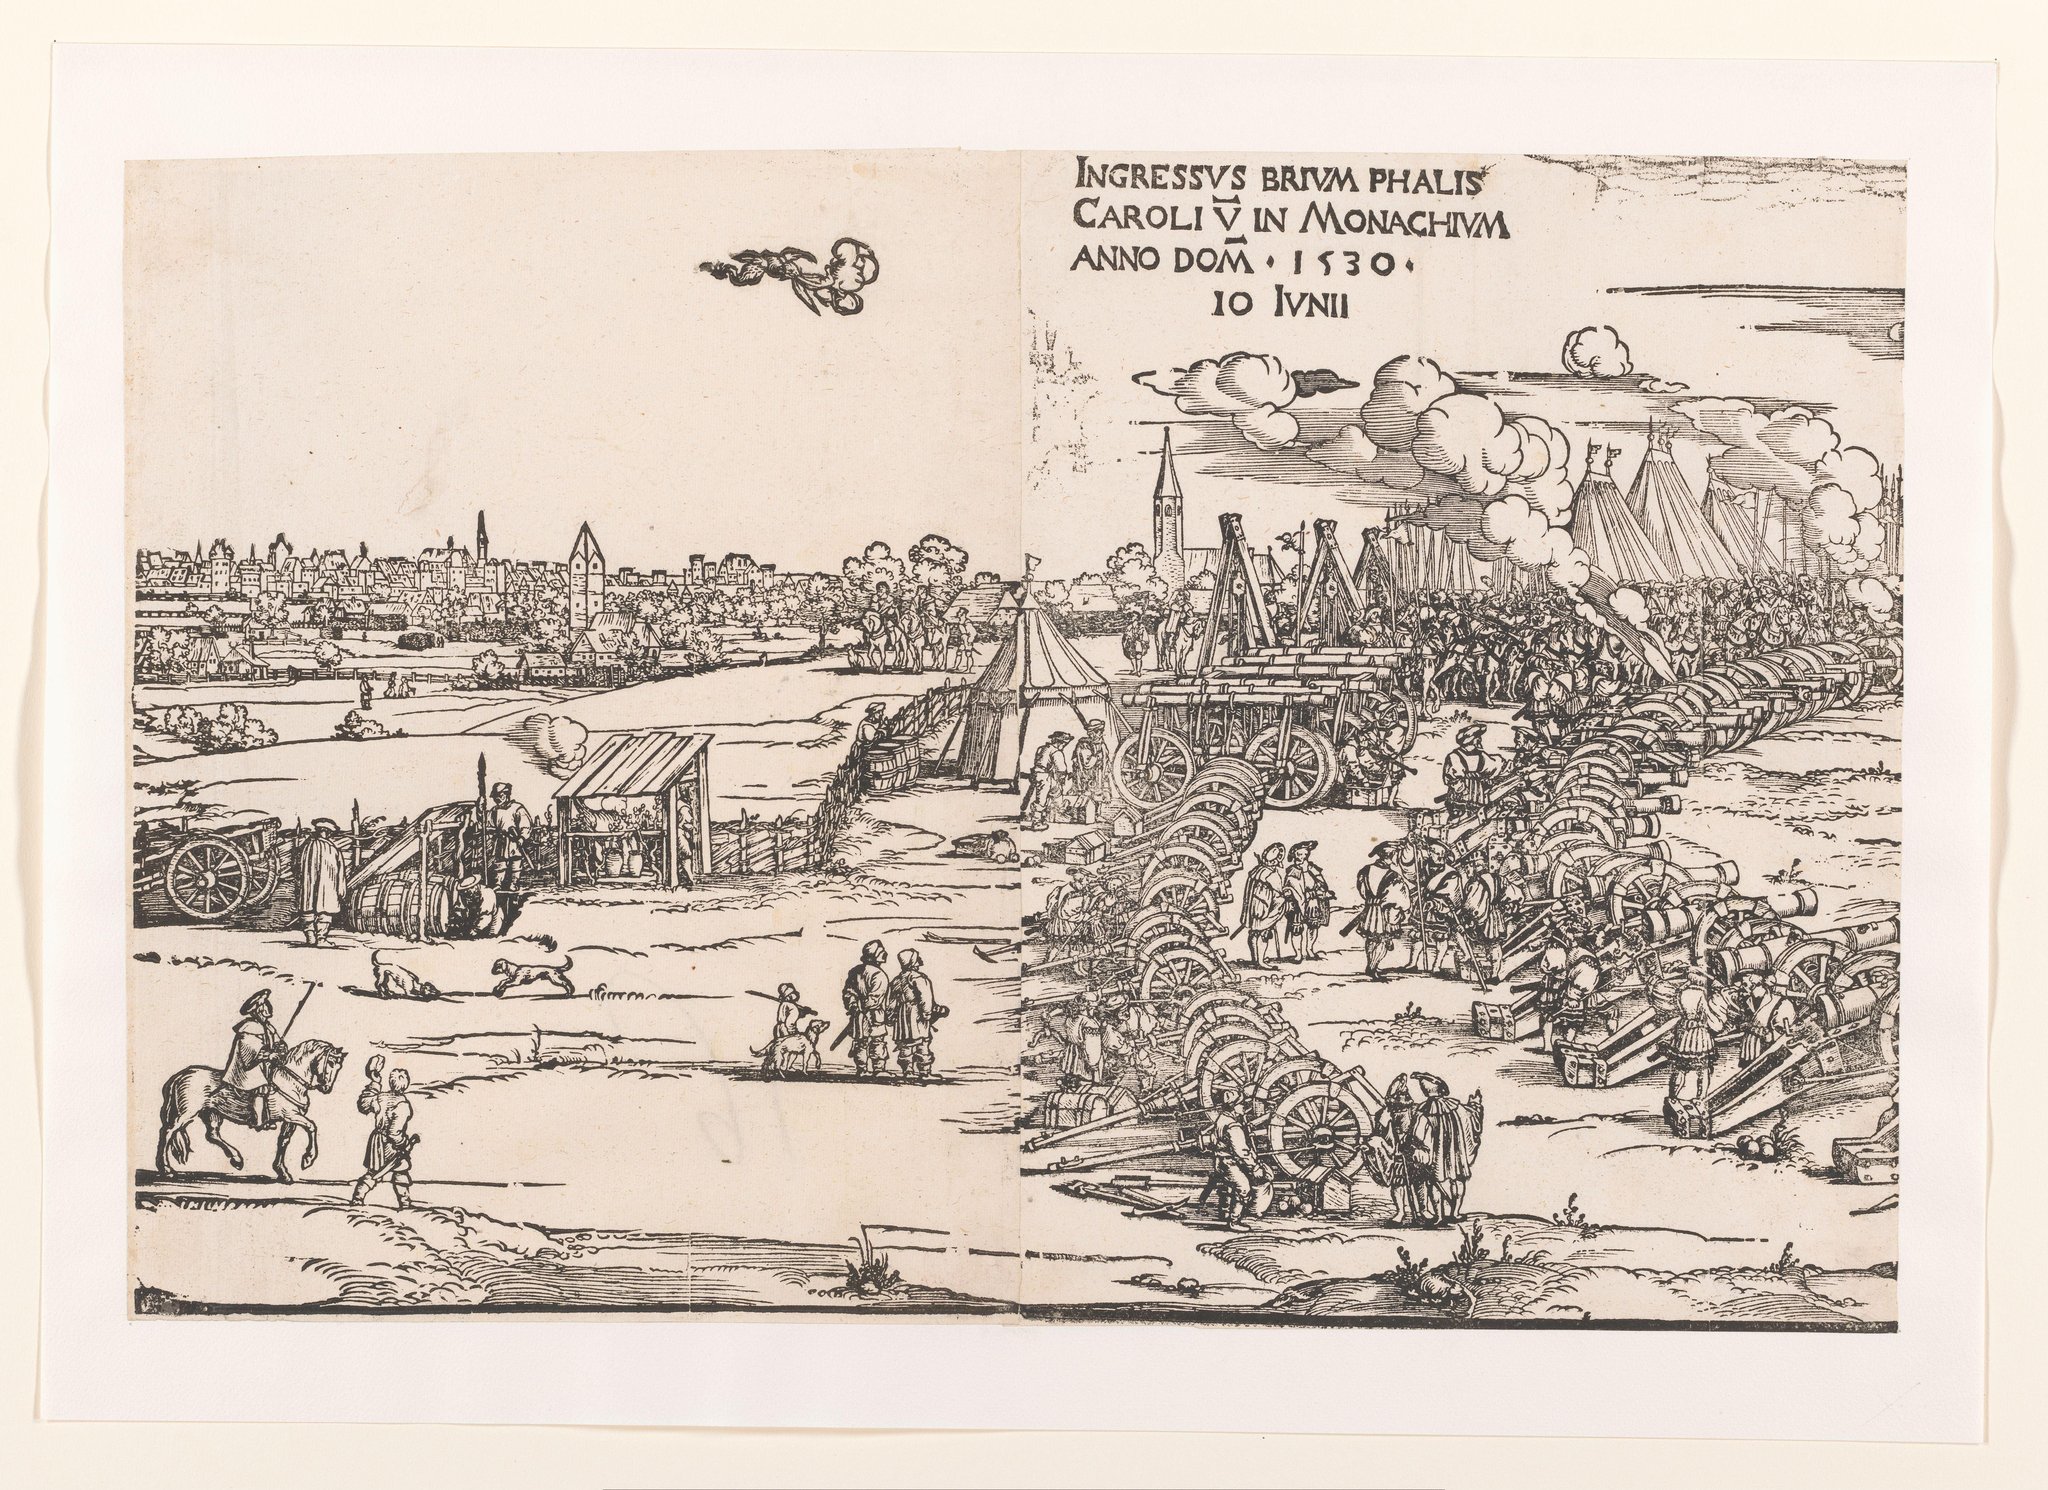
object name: print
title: Gezicht op München met militair schouwspel (middelste deel)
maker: Anonymous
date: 1530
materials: paper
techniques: woodcut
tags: ghent, charles v (holy roman emperor and king of spain), city-view in general; 'veduta', triumphal entry and public reception, pageant, 'entrée solennelle', 'joyeuse entrée', military parade, pageant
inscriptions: collector's mark: Lugt 240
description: Onderdeel van het stadsgezicht met militair schouwspel. Dit geheel bestaat uit vijf bladen, dat in drie stukken gedeeld. Het hier beschreven deel bestaat uit twee bladen.